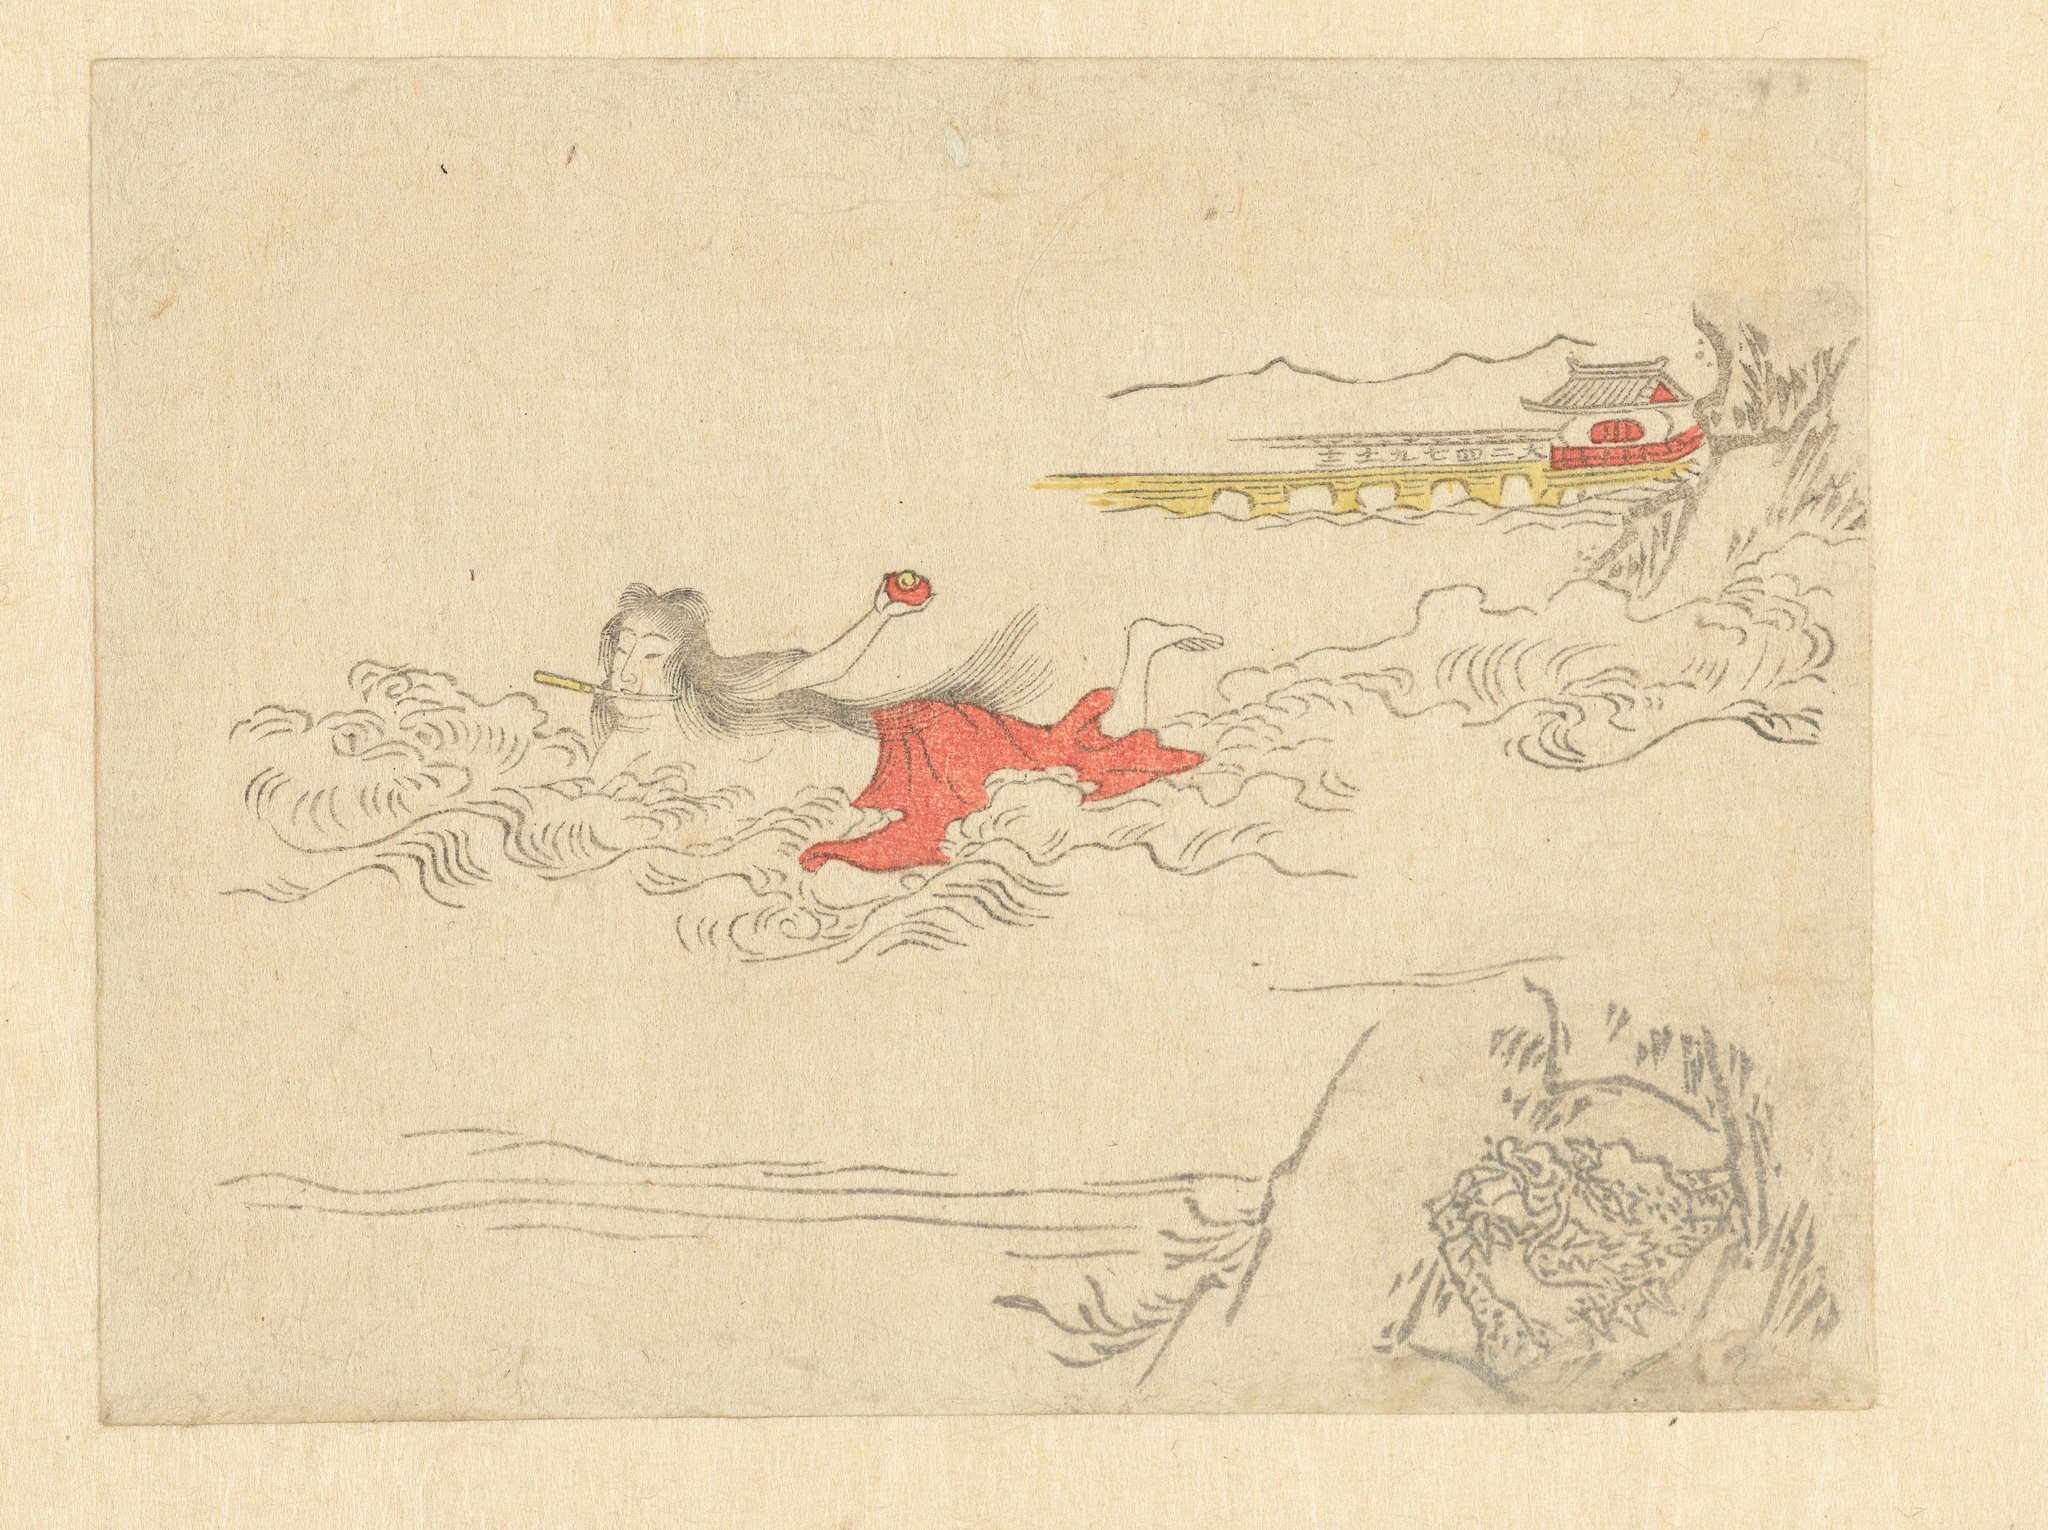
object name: print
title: Awabi duikster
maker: Anonymous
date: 1796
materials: paper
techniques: woodcut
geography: japan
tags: pearl fishing, pearl diving; coral fishing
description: Een surimono is een luxe uitgevoerde prent waarop beeld met één of meerdere gedichten gecombineerd is. Bij het drukken van een surimono werd vaak gebruik gemaakt van dikker papier, blinddruk en metaal pigmenten, zoals koper- en zilverpoeder. De prenten werden vaak in opdracht van dichters gemaakt en als exclusief geschenk aan vrienden en relaties gegeven. Een egoyomi is een kalender prent, waarop de aanduiding voor de maanden verstopt zit in het ontwerp. Vaak werden egoyomi net als surimono in eigen beheer uitgegeven en aan vrienden kado gedaan. In Japan gebruikte men tot 1873 een maankalender, waarbij de volgorde van de lange en de korte maanden jaarlijks varieerde. Omdat er maar een klein aantal uitgevers kalenders mocht maken, waren particulier uitgeven kalender prenten tegen de regels van de overheid. Om deze regels te omzeilen werden de kalendergegevens verstopt in het prentontwerp.